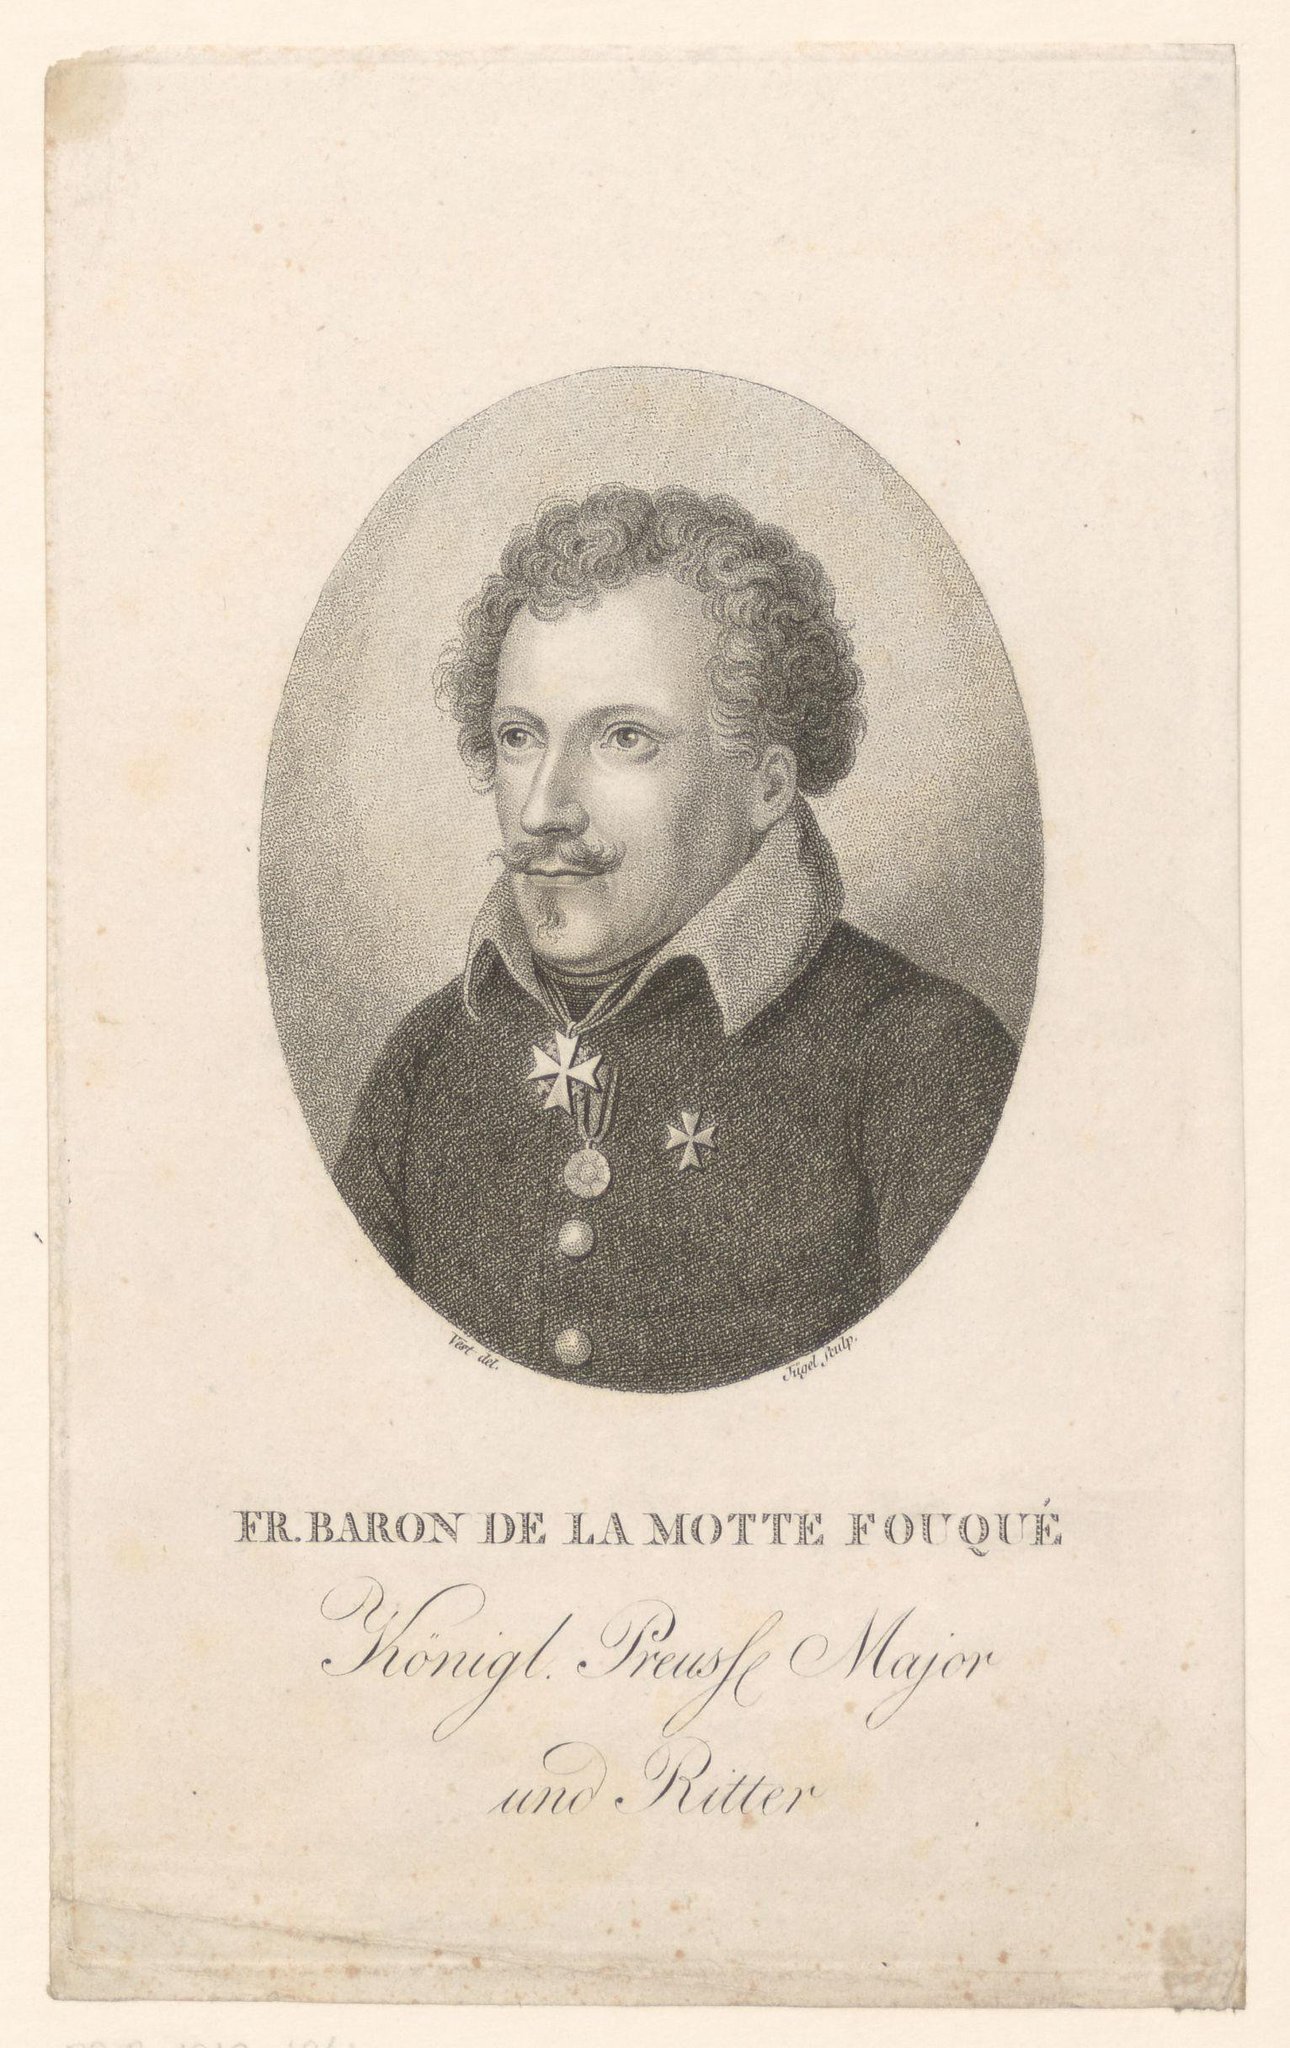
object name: print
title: Portret van Friedrich de la Motte Fouqué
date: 1787-1833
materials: paper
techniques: stippling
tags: berlin, historical persons, officer, writer, poet, author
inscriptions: collector's mark: Lugt 2228